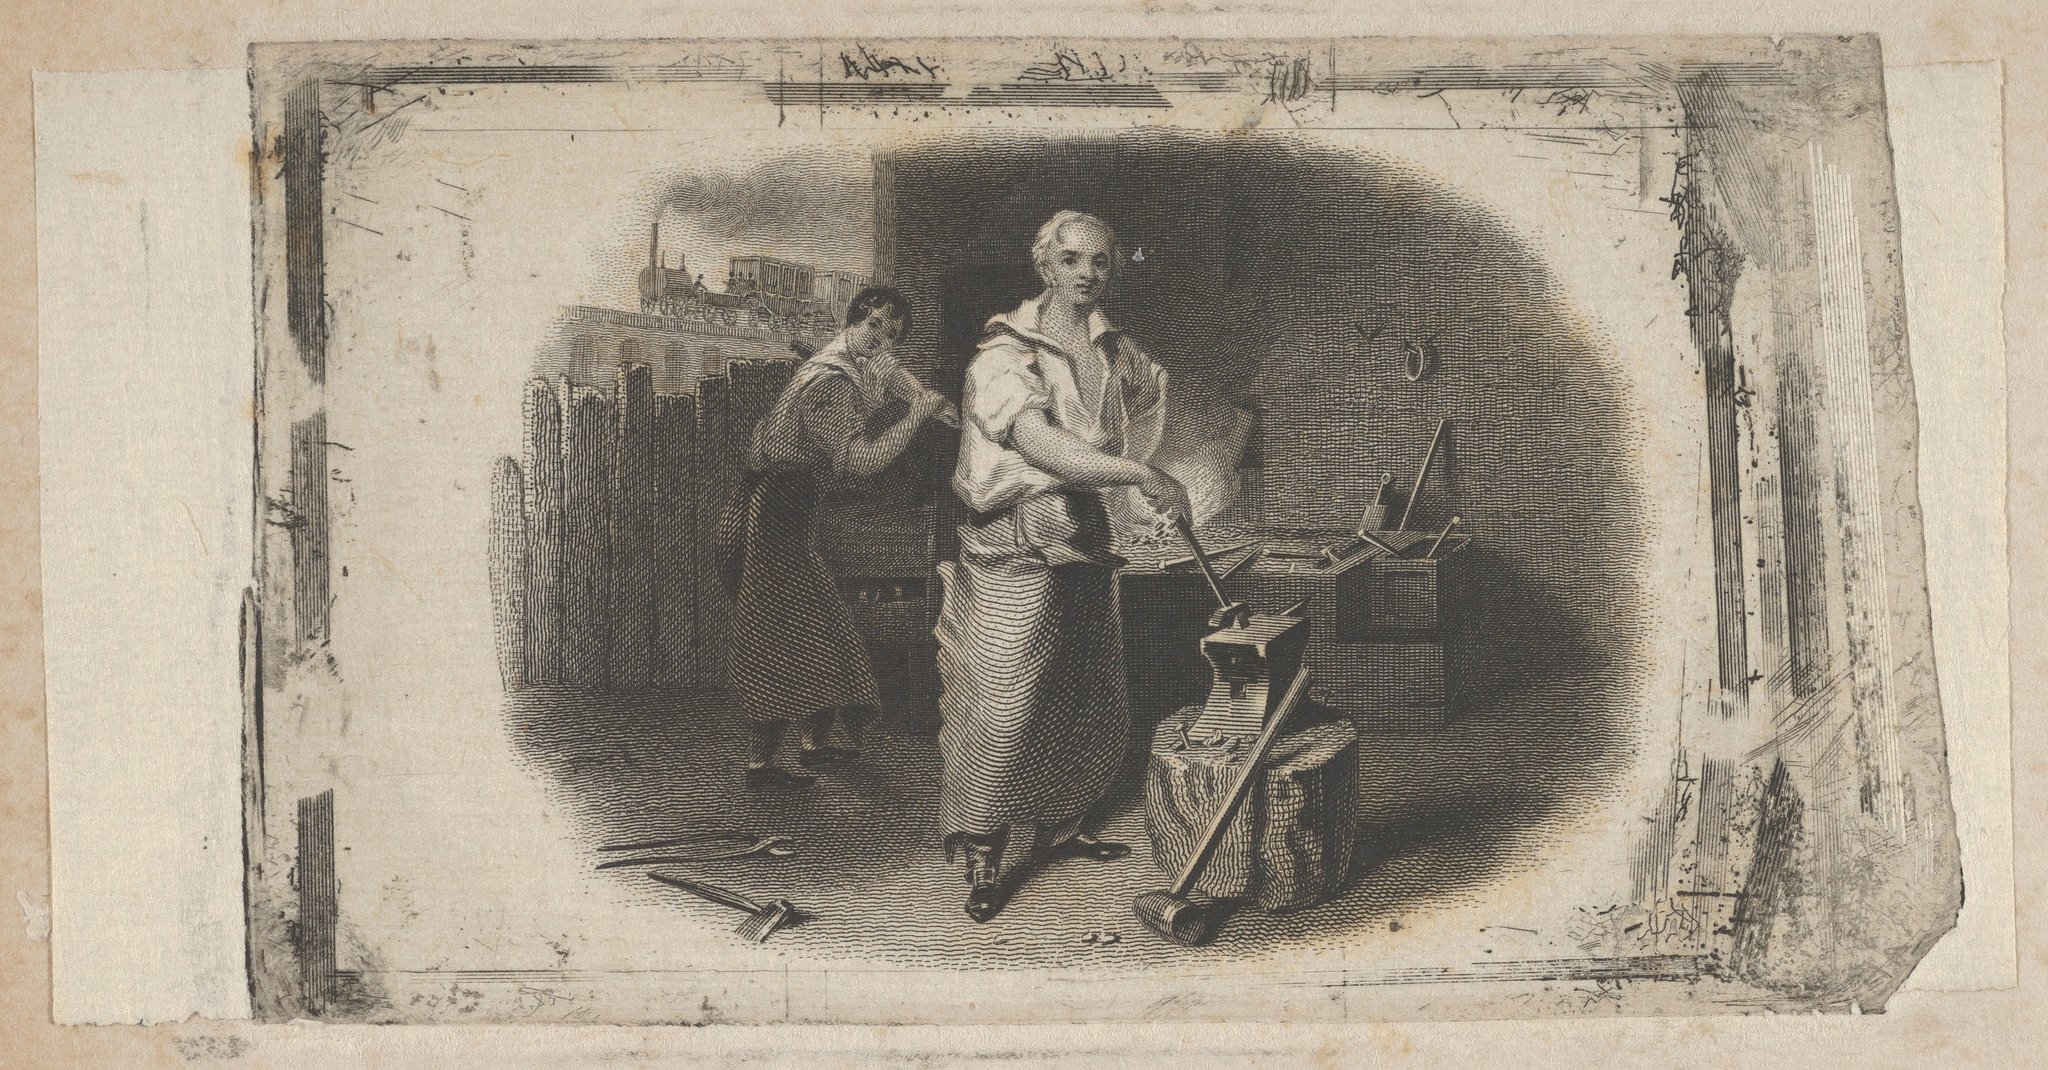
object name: print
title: Banknote vignette with a blacksmith and forge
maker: asher brown durand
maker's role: artist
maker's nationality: american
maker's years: 1796-1886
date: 1824-1837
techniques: printmaking, engraving, etching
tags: men,working,money,blacksmiths